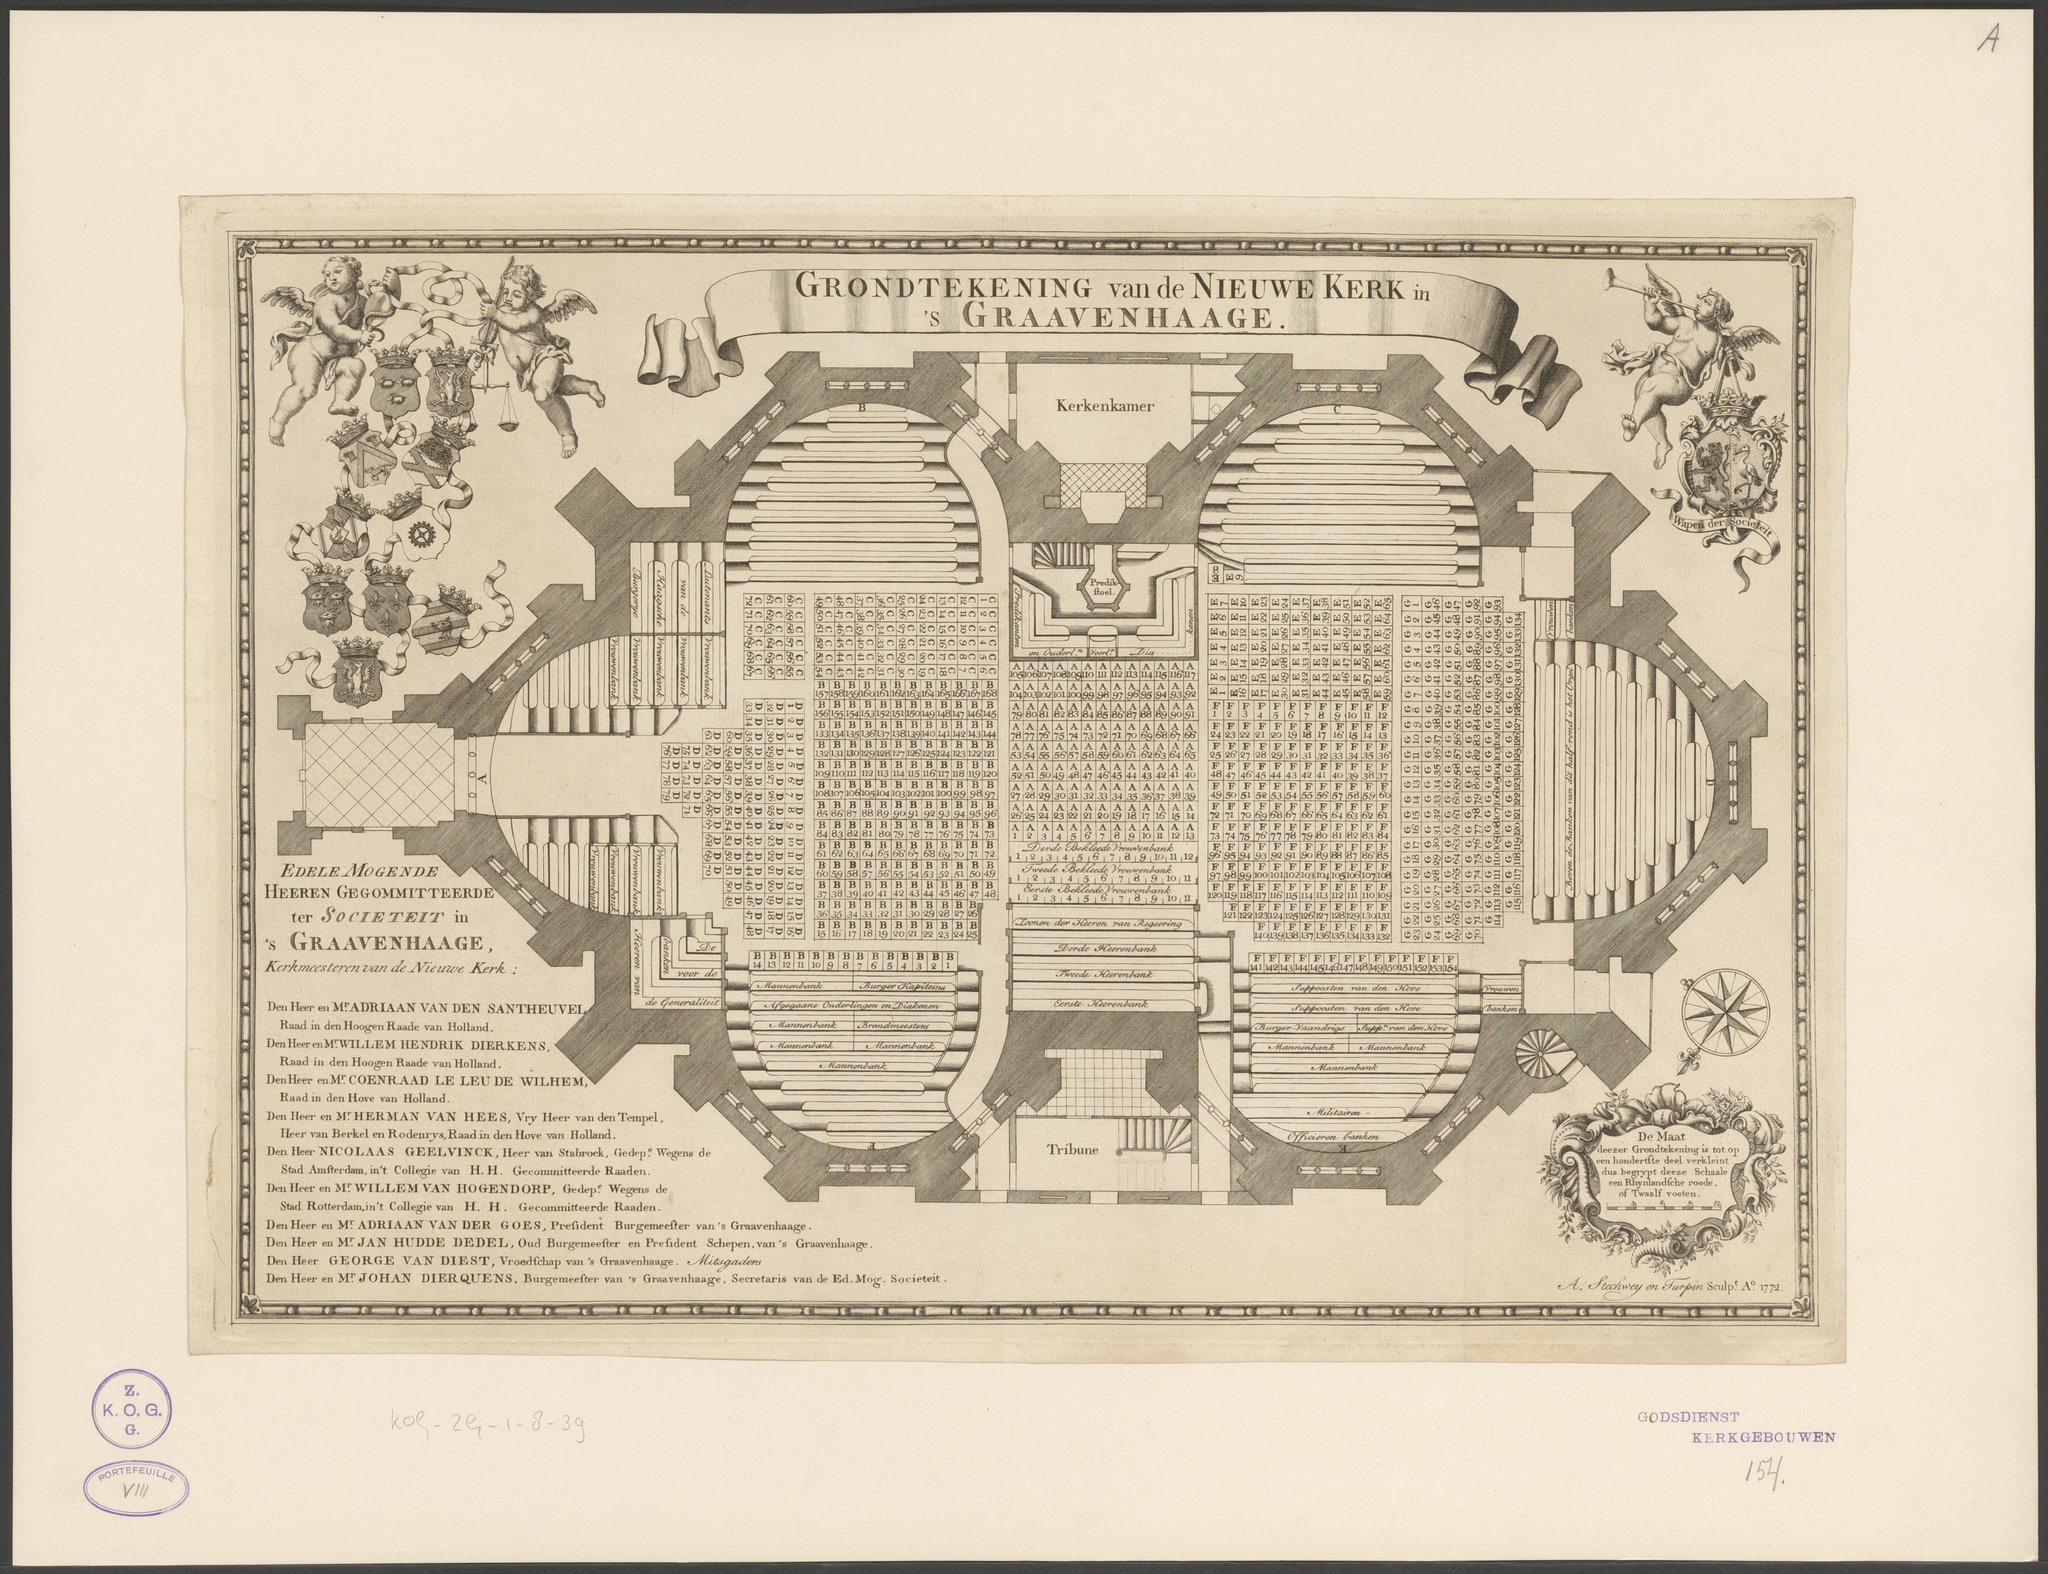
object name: print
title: Plattegrond van de Nieuwe Kerk te Den Haag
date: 1772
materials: paper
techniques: engraving, etching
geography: netherlands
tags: the place of worship and its equipment ~ christian churches, plan ~ architecture, armorial bearing, heraldry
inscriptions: collector's mark: Lugt 1641, collector's mark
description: Plattegrond van de Nieuwe Kerk aan het Spui te Den Haag. Met namen en wapens van de gecommitteerden en kerkmeesters van de Nieuwe Kerk en van de Sociëteit. Rechtsonder een cartouche met de schaalstok. Onderwerpsrubrieken binnen de Atlas Zeden en Gewoonten: Kerk en kerkwezen & Armwezen en liefdadige instellingen; Kerkgebouwen elders. F-L.